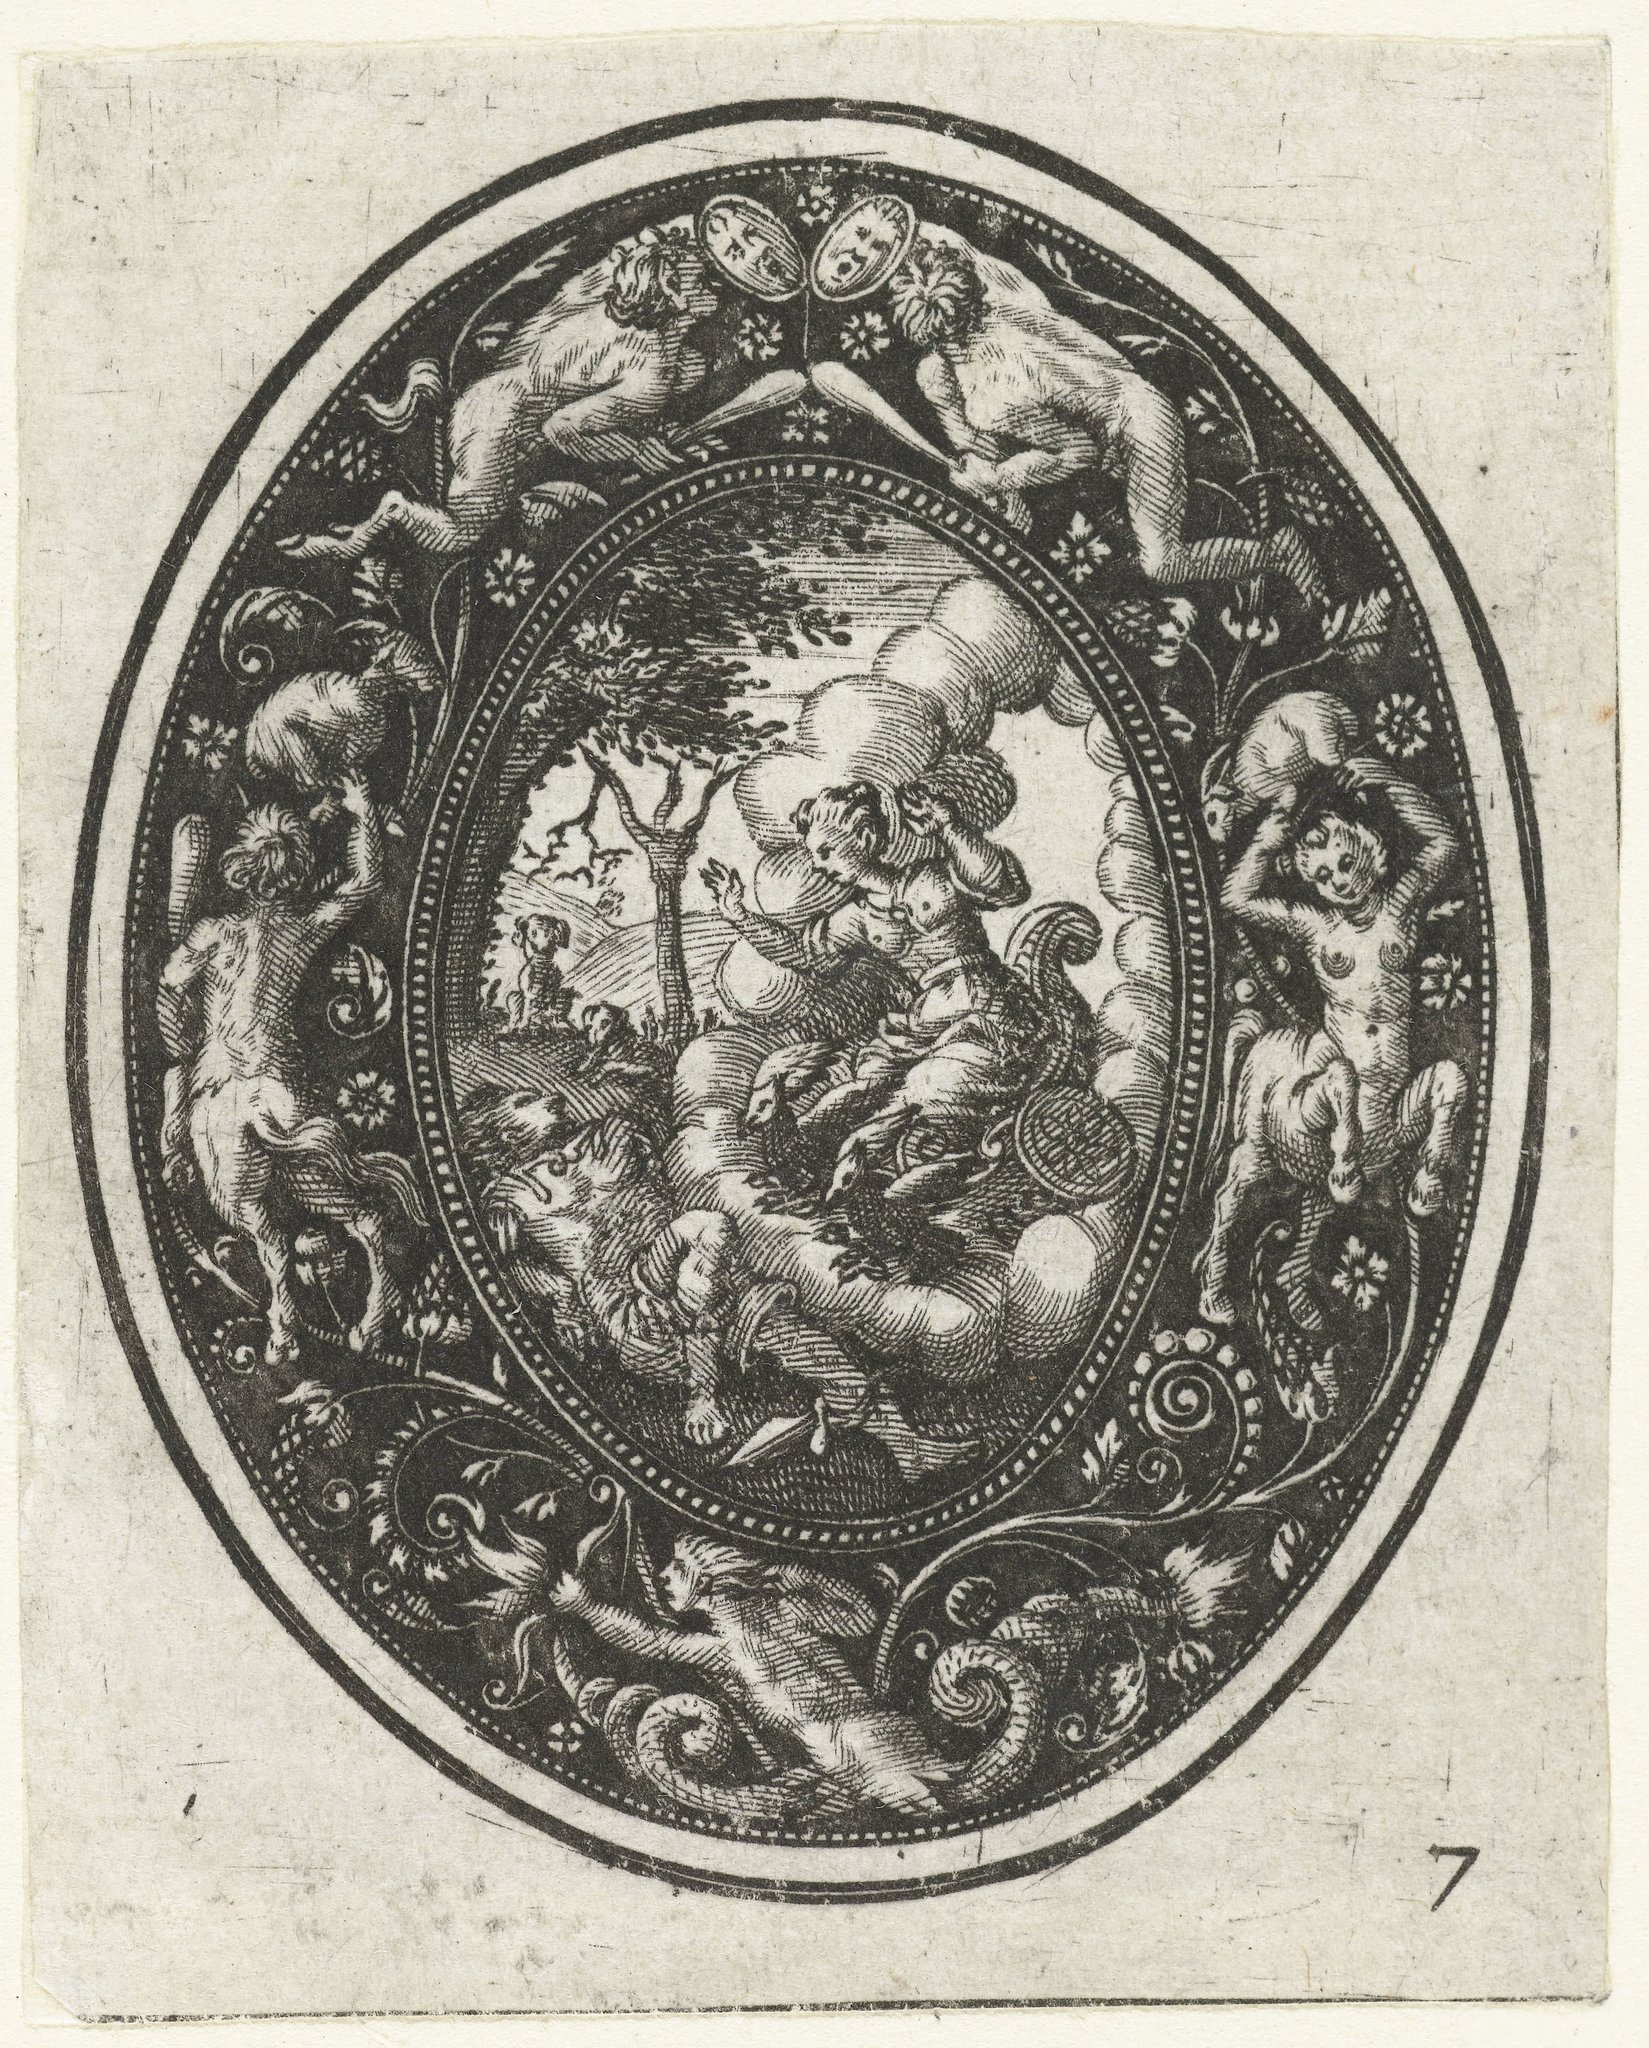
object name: ornament print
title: Rand met groteske figuren en ranken rond medaillon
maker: antoine jacquard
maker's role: print maker, publisher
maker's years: -1640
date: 1610-1615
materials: paper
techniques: engraving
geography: france